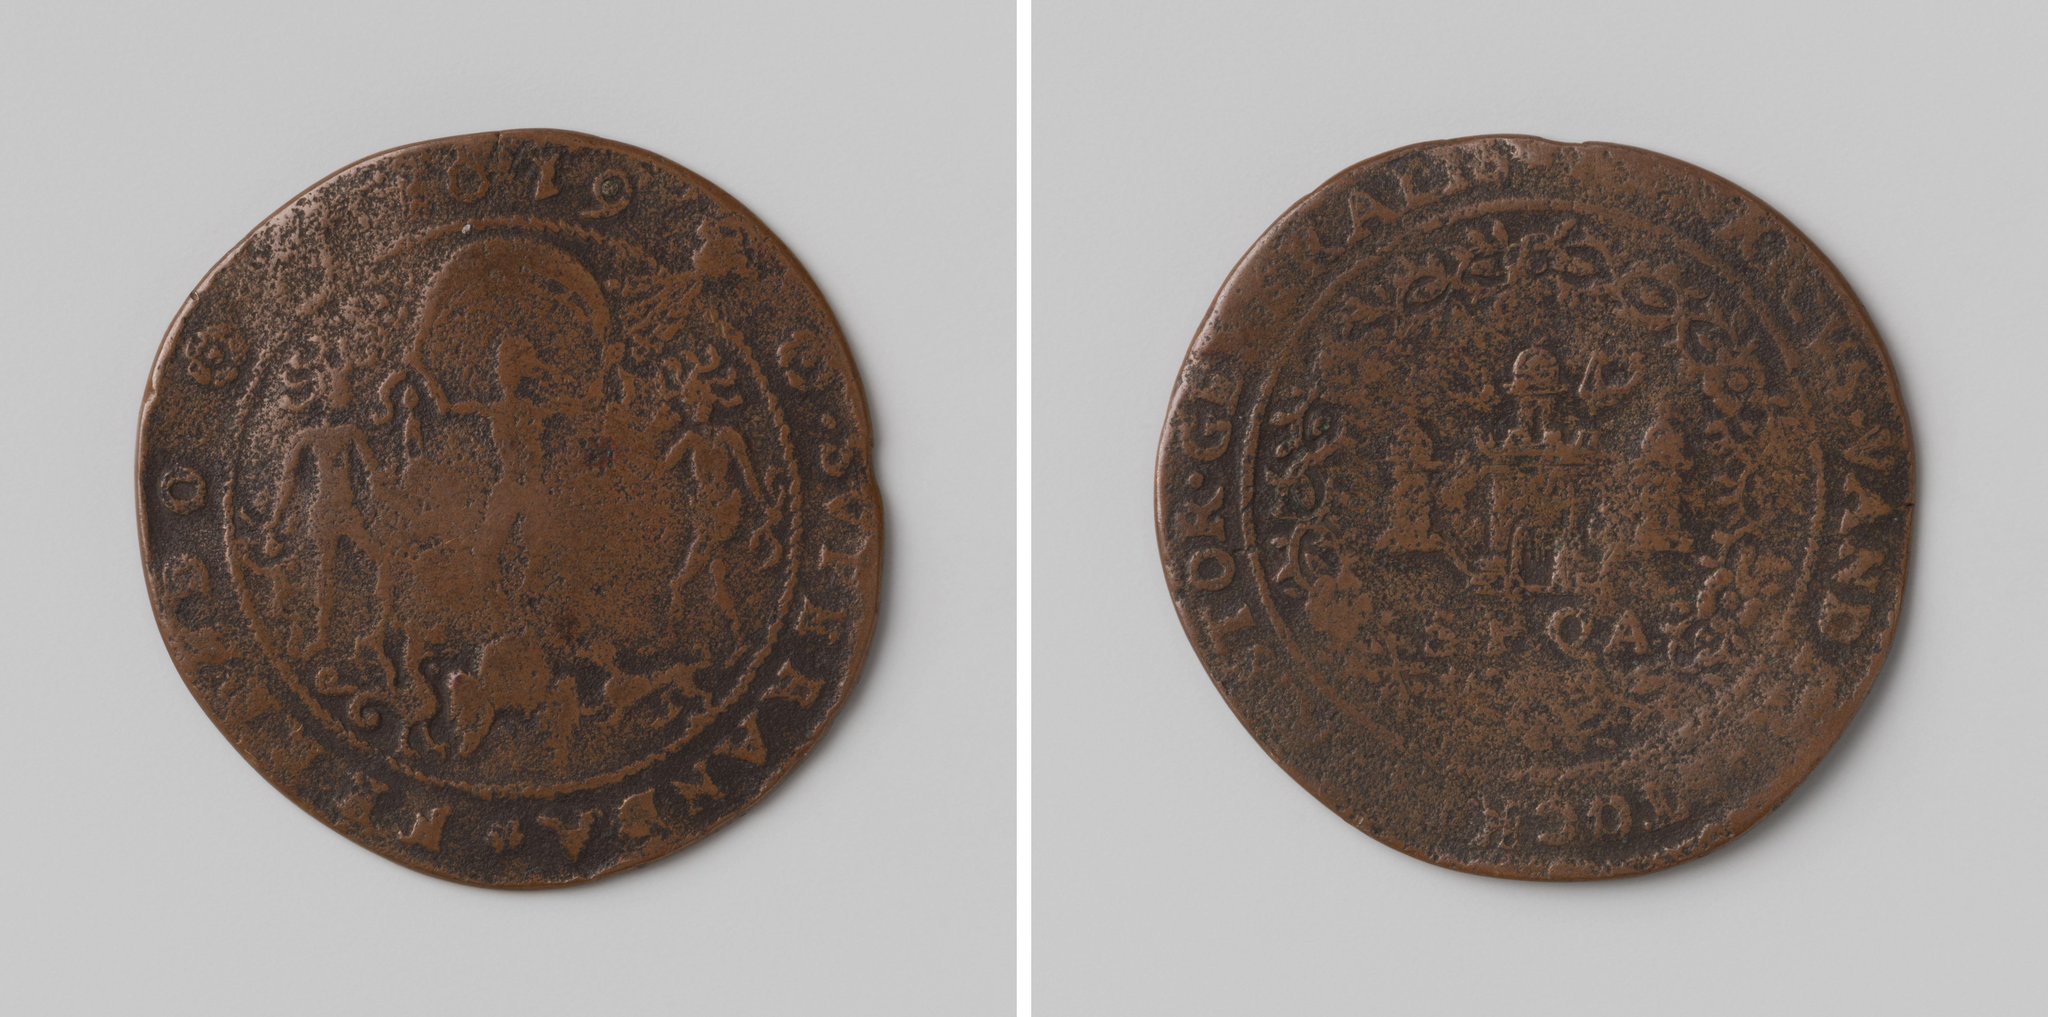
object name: jeton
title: Hendrik Vanderstock, algemeen schatmeester van de stad Antwerpen, rekenpenning geslagen op last van de stad Antwerpen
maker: Anonymous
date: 1619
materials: copper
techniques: striking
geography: antwerp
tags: antwerp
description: Koperen penning. Voorzijde: Fortuin, staande op gevleugelde bol, aan weerszijden aangevallen door een stormwind, een furie en een gedrocht binnen omschrift. Keerzijde: burcht onder twee handen binnen krans van rozetakken en omschrift